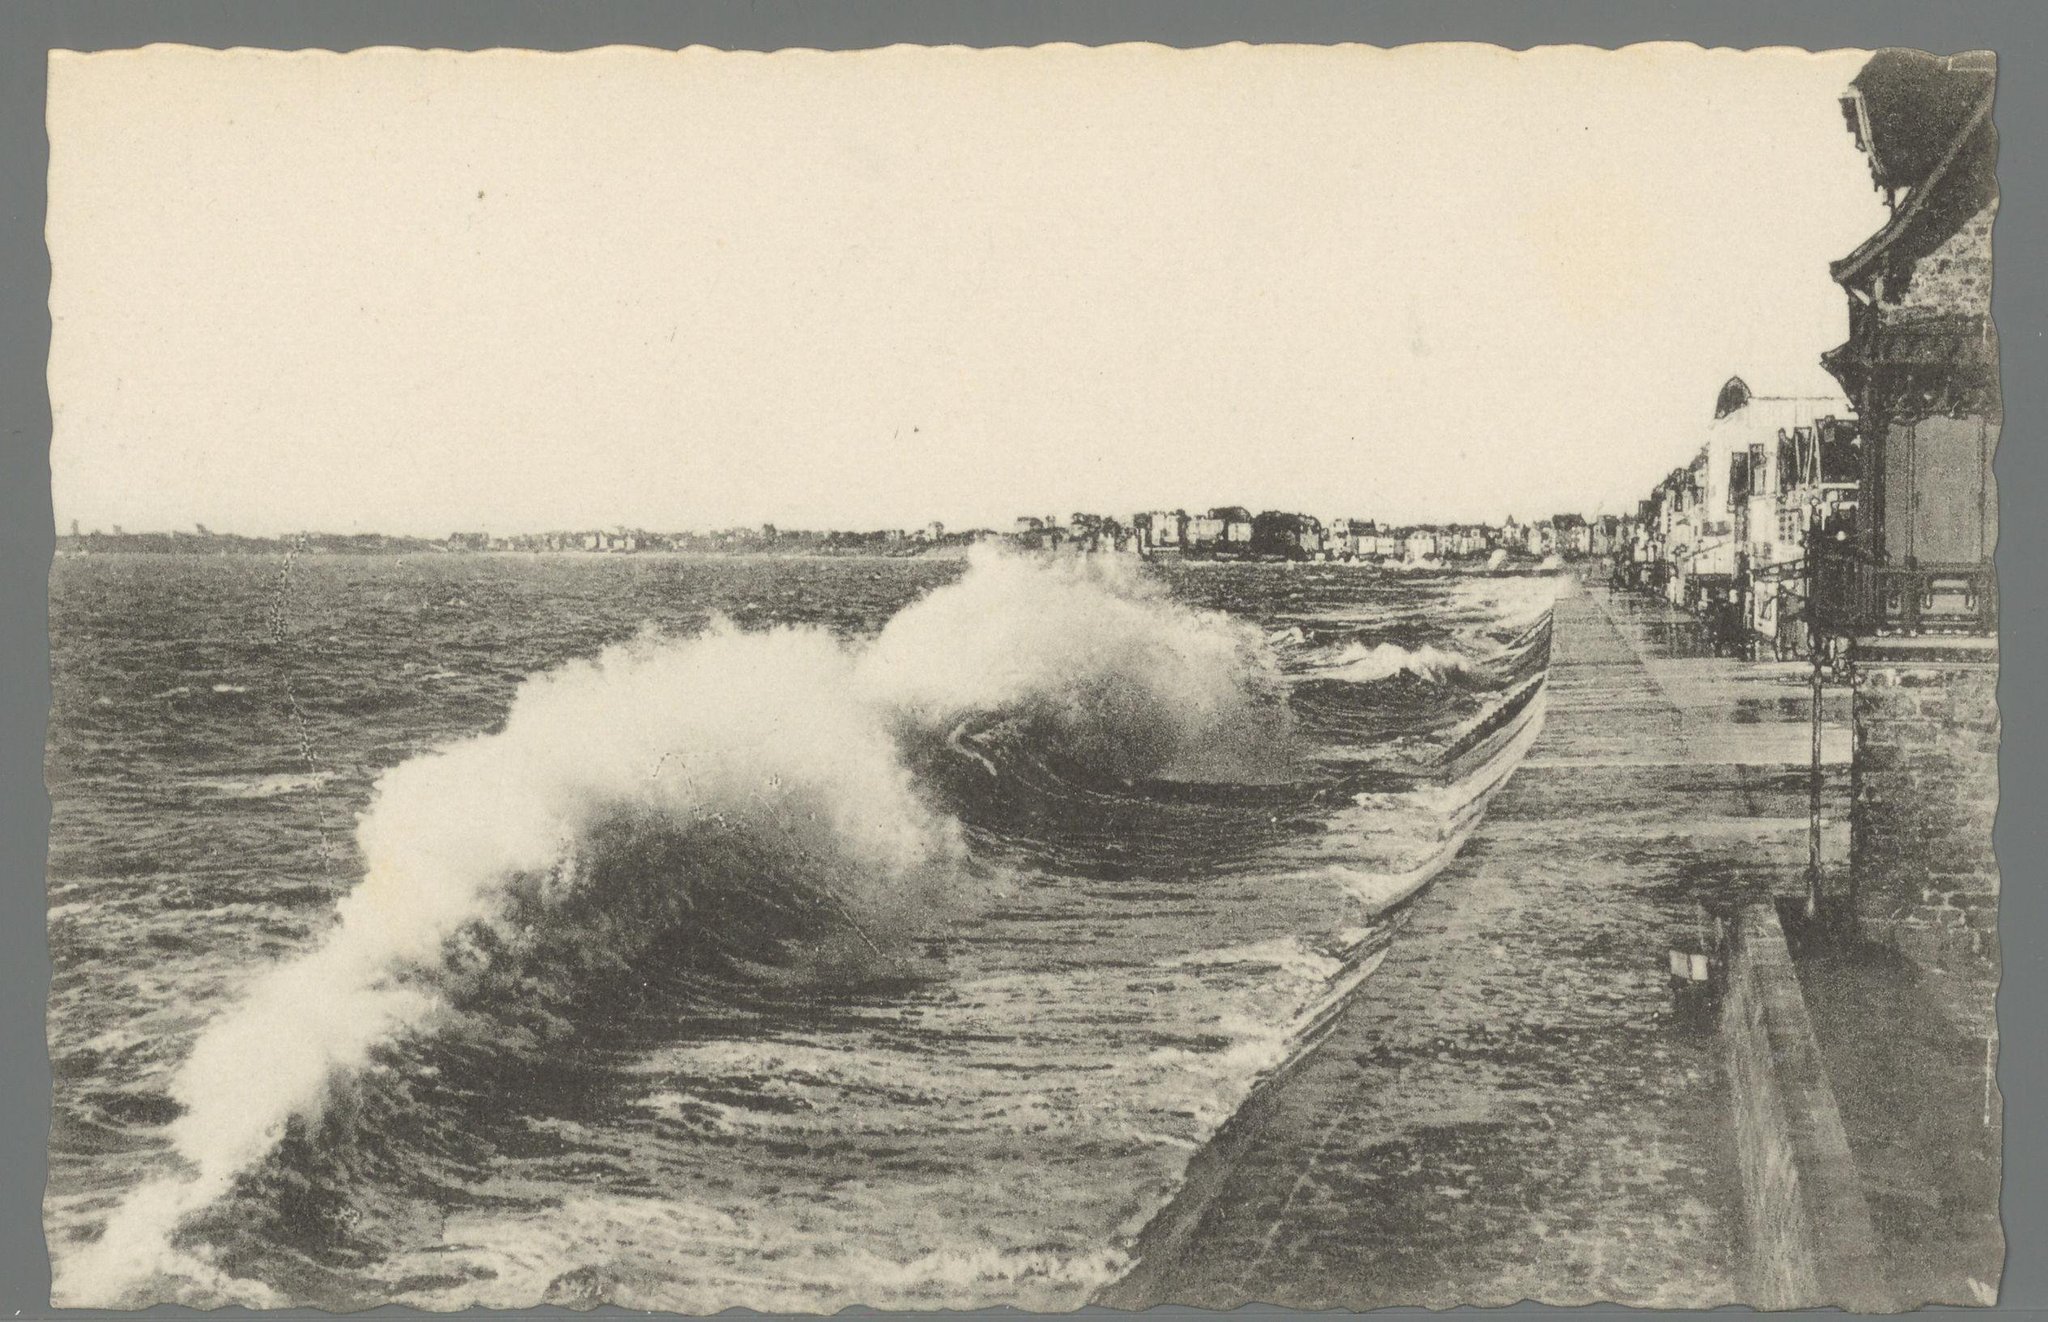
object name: photomechanical print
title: St. Malo. La Digue par gros temps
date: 1932-1940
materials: cardboard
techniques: photograph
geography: paris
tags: city-view, and landscape with man-made constructions, tidal wave, coast